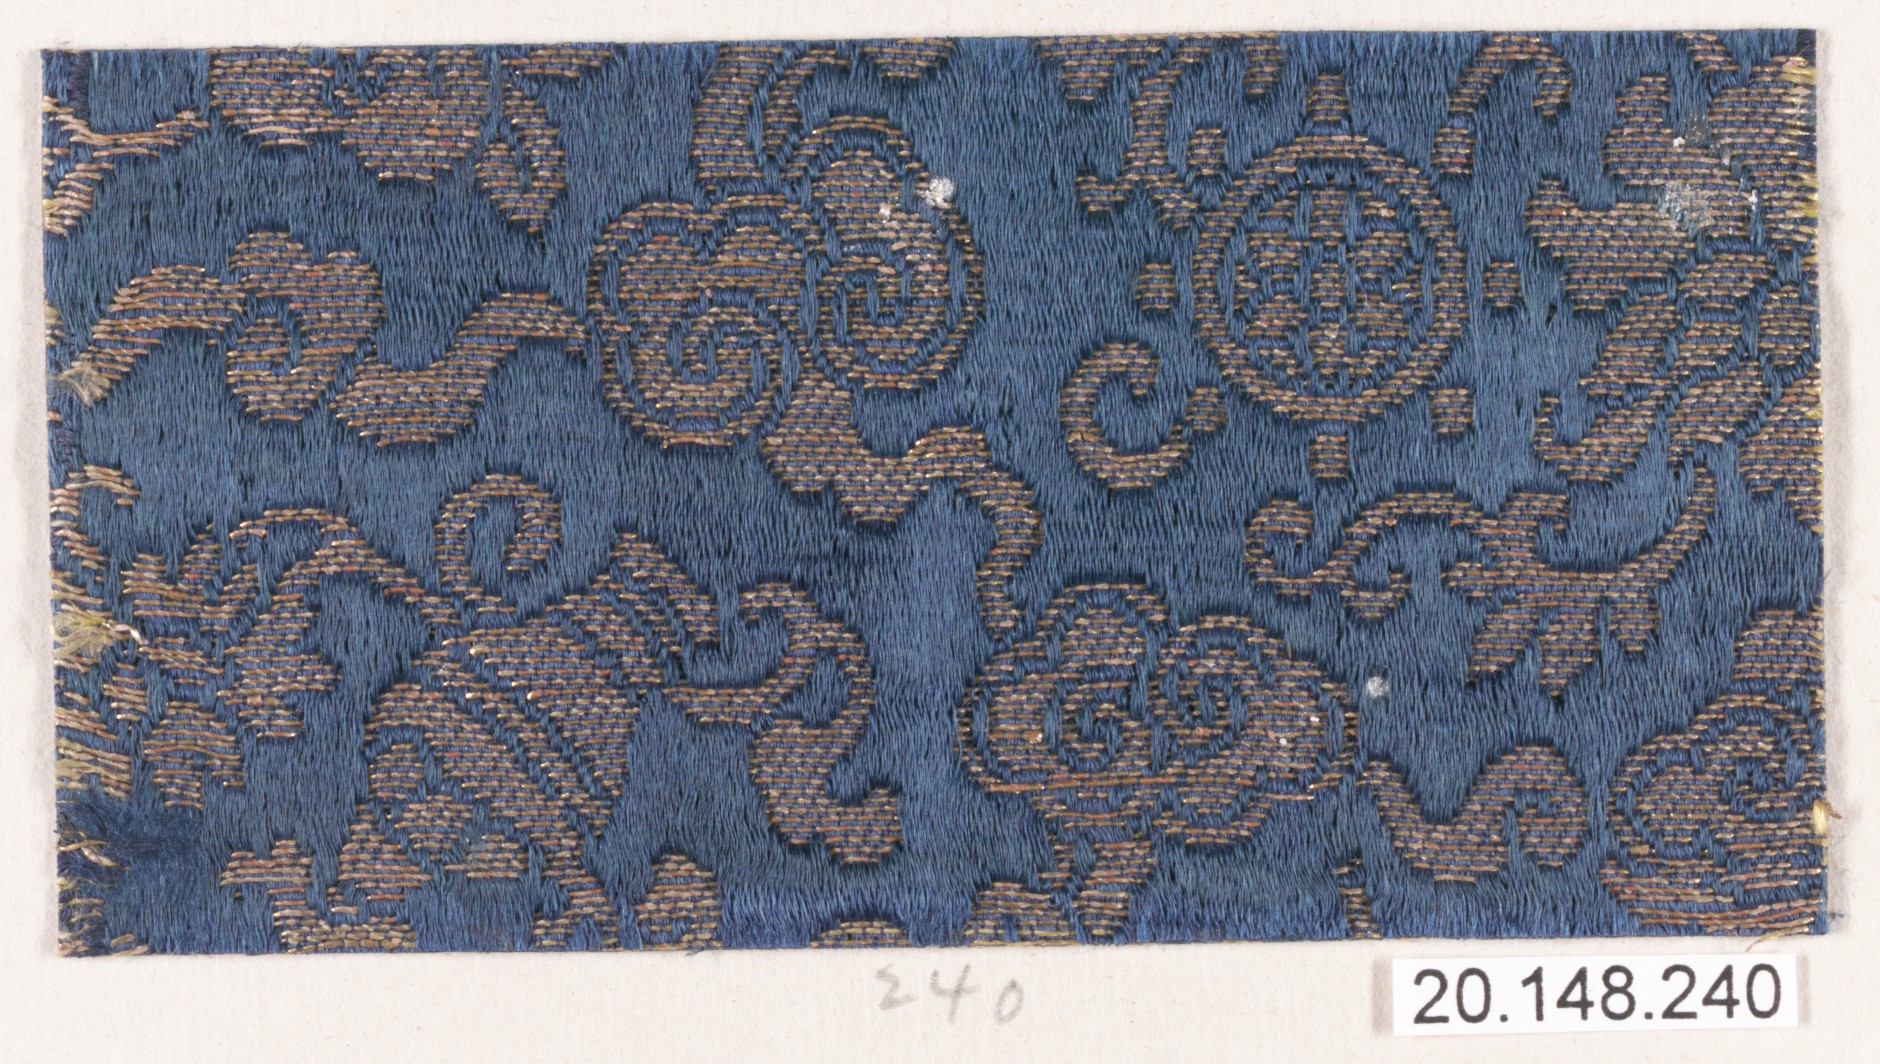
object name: piece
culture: japanese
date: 1701-1800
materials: silk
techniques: compound weave